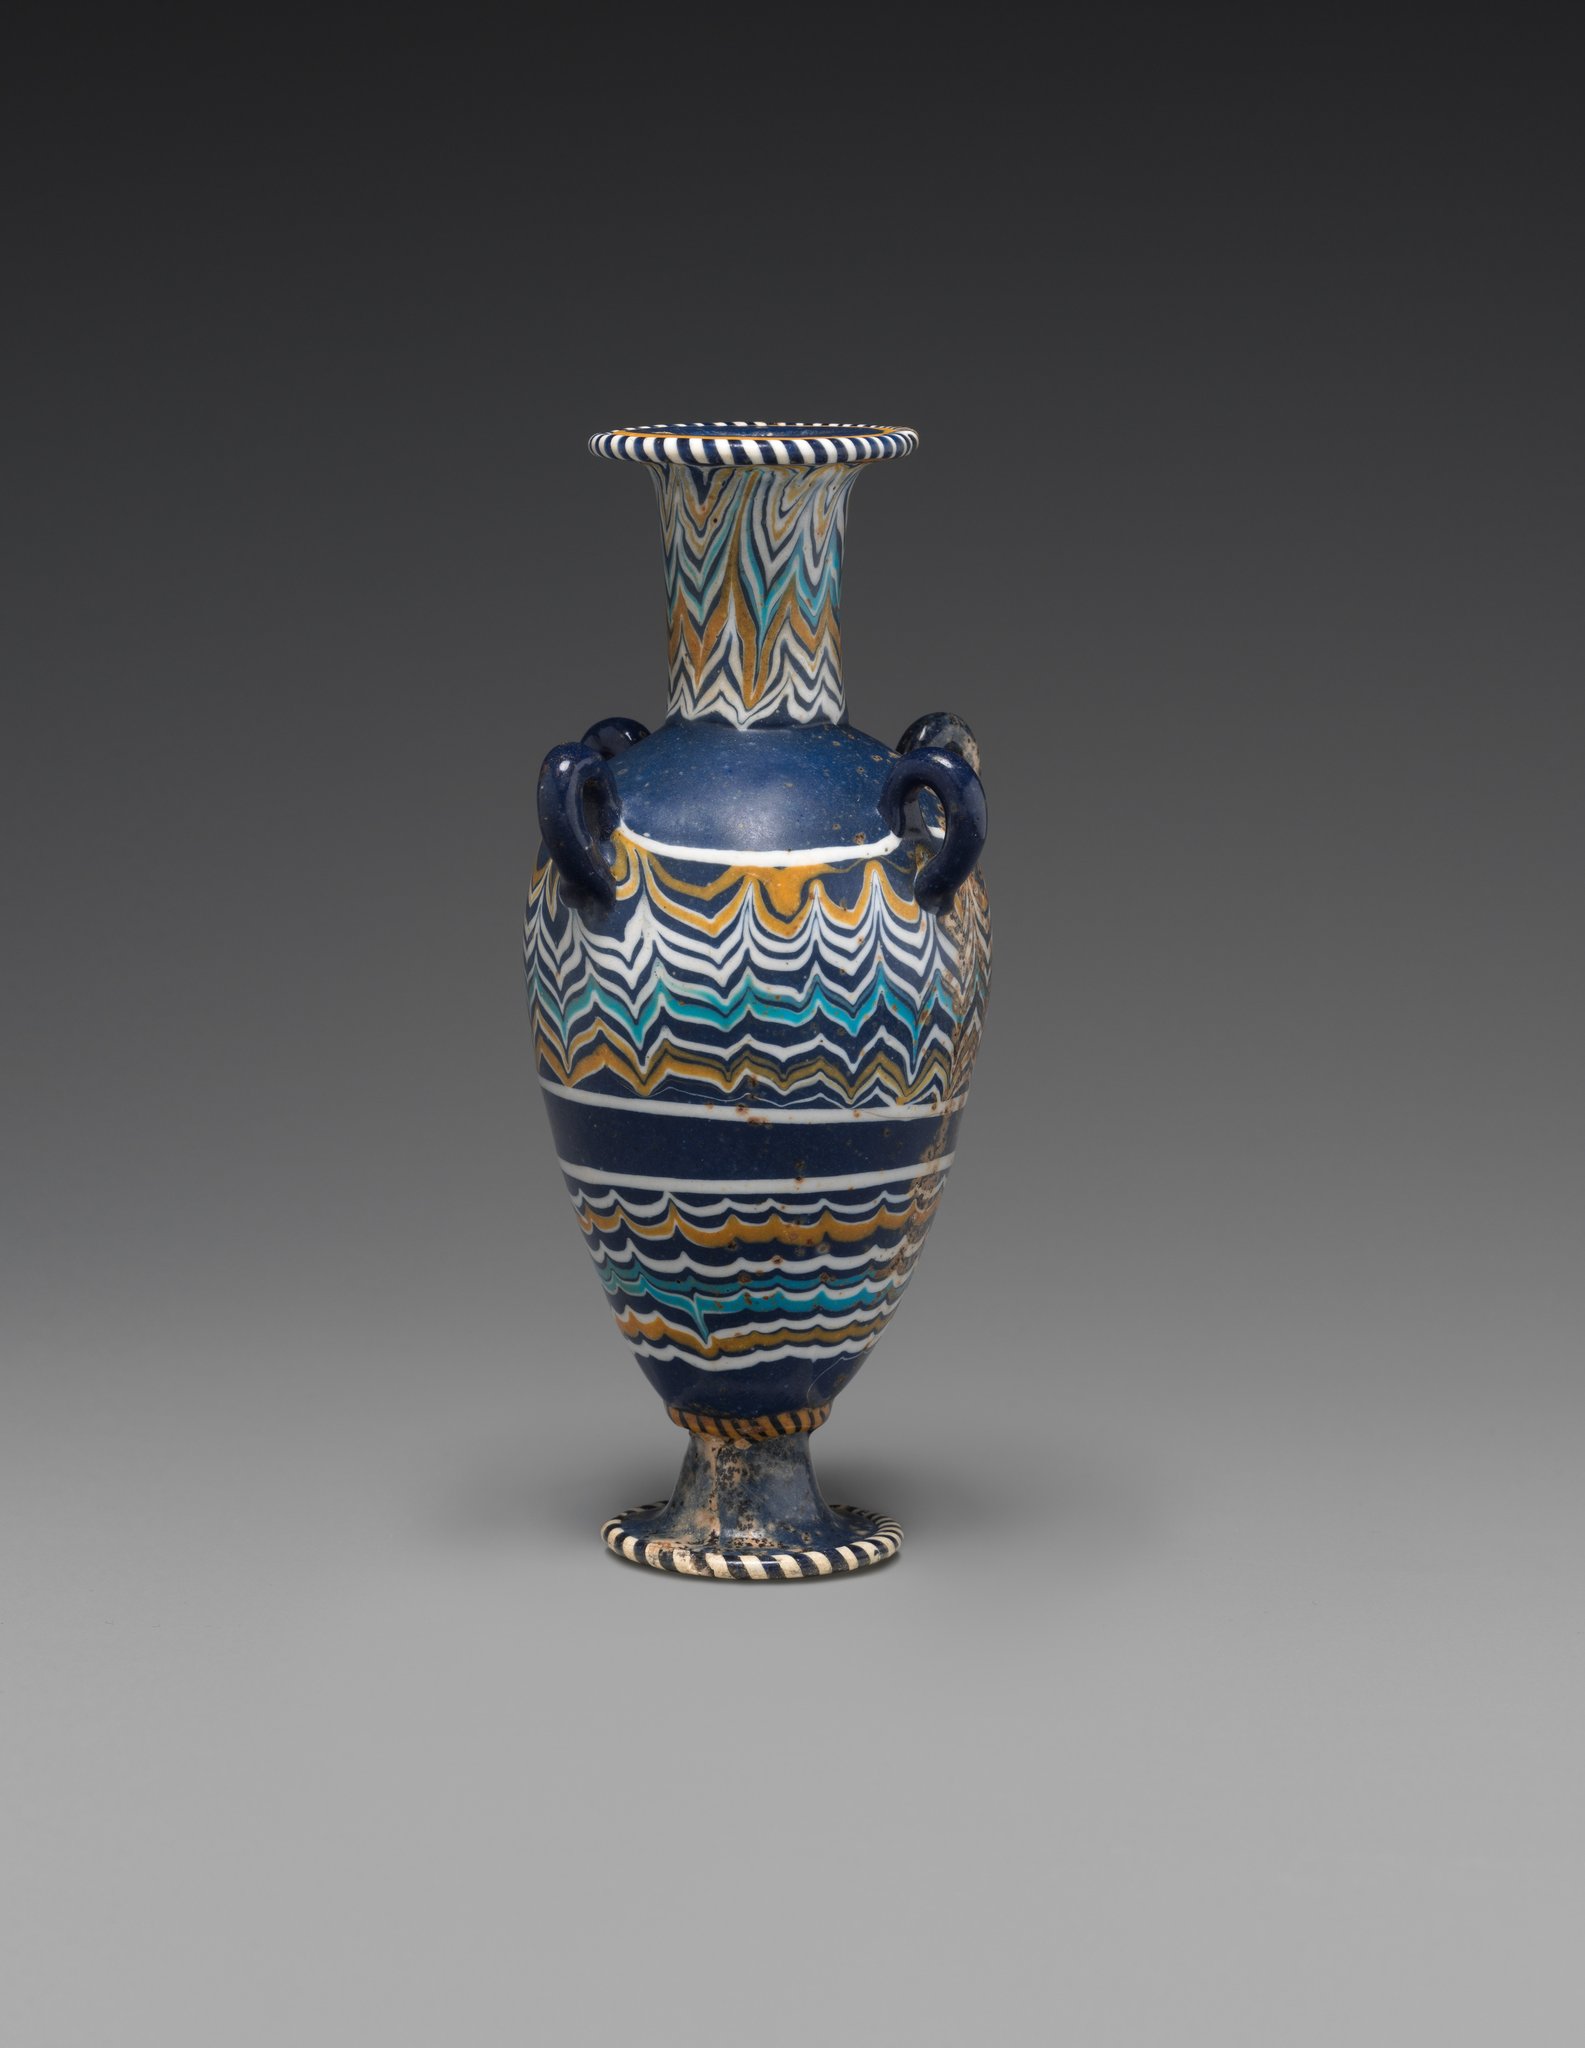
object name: bottle, amphora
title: Amphora-shaped perfume bottle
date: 1390-1336 BCE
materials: glass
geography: egypt